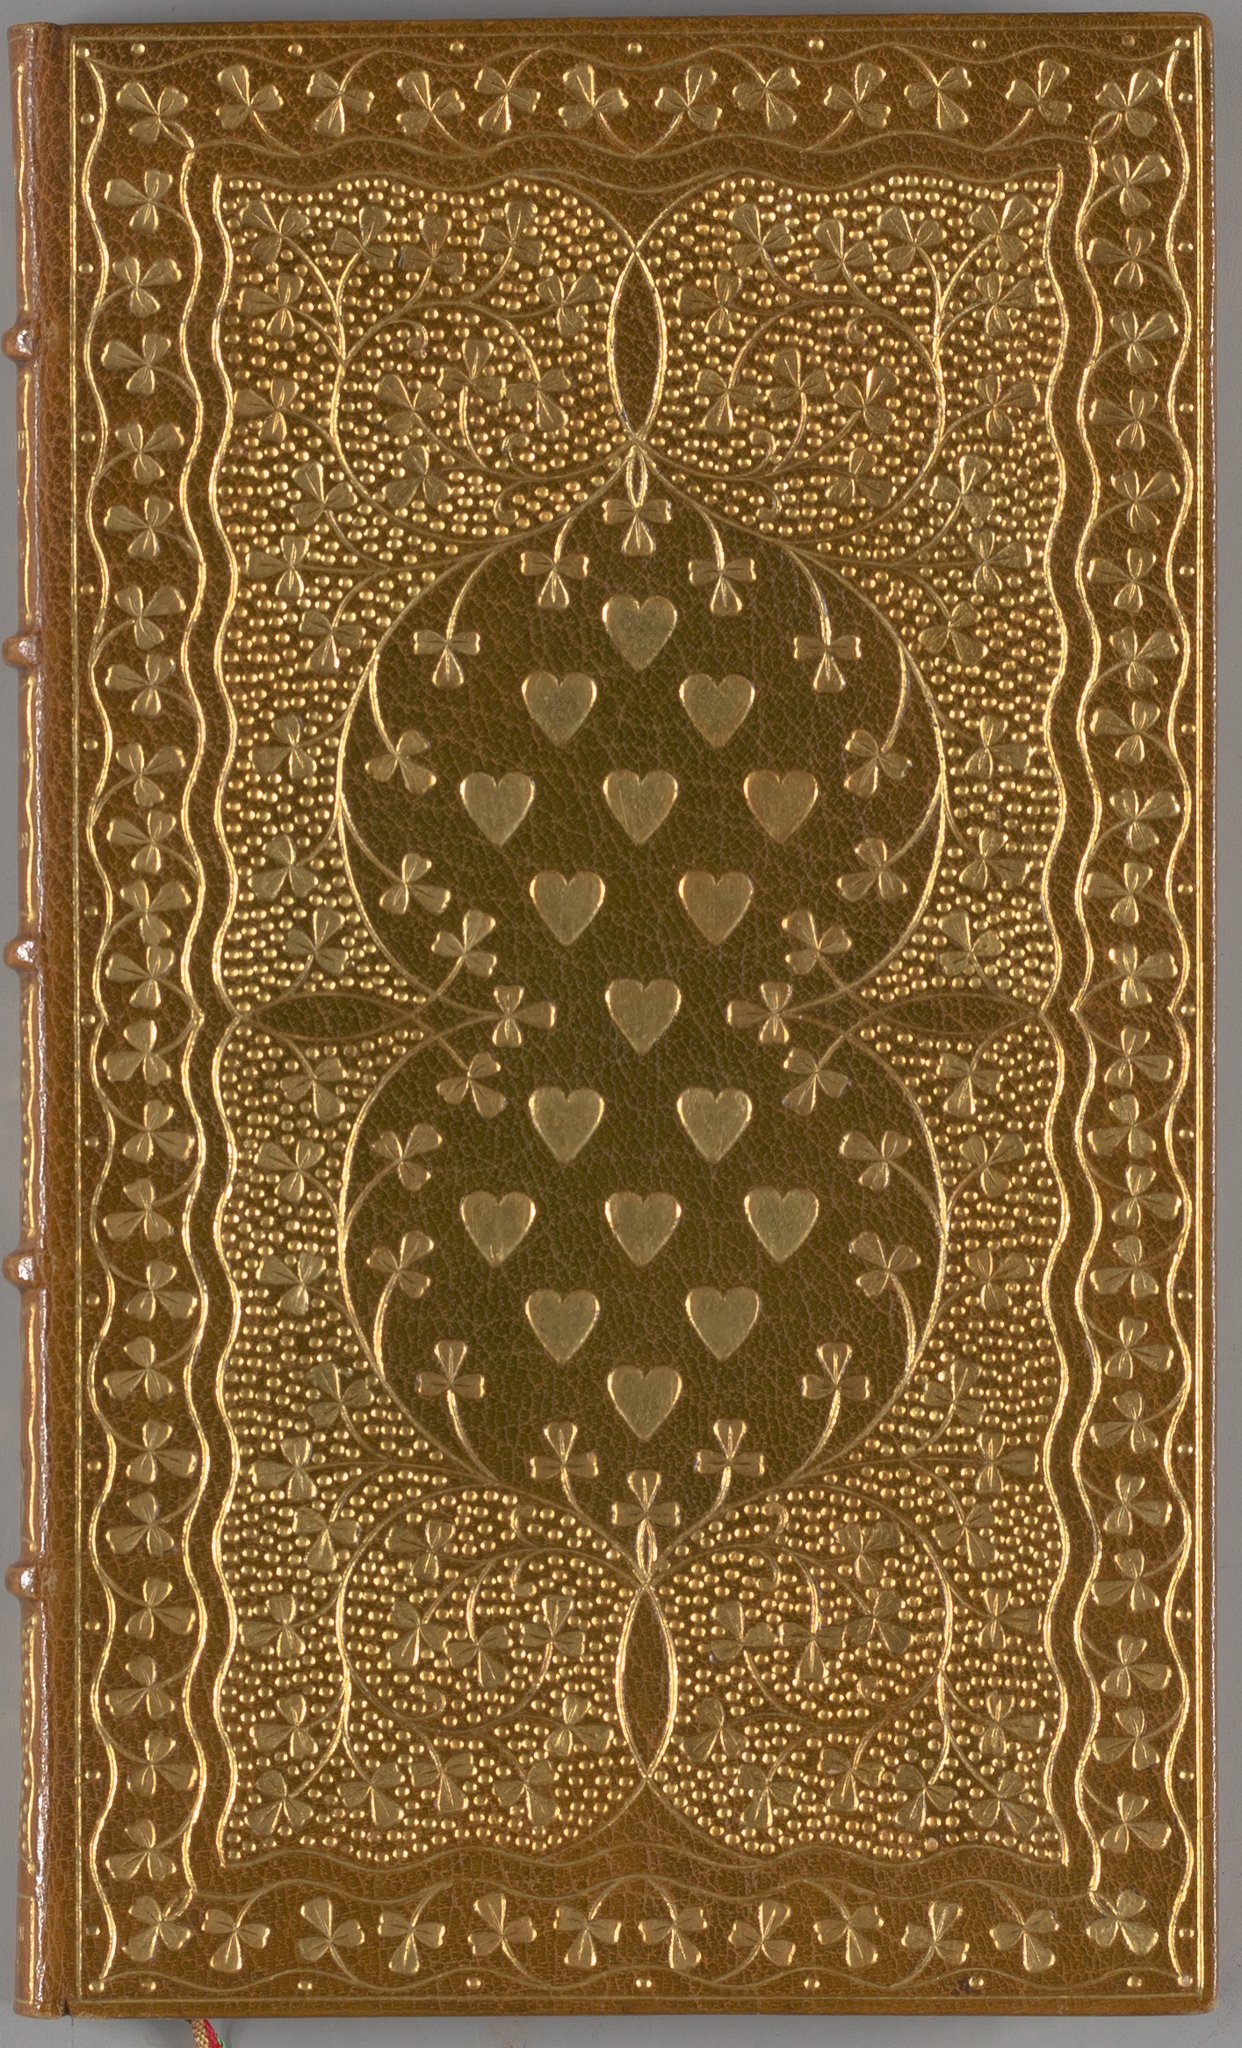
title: Irish love-songs / selected by Katharine Tynan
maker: katharine tynan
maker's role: editor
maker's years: 1861-1931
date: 1892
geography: england